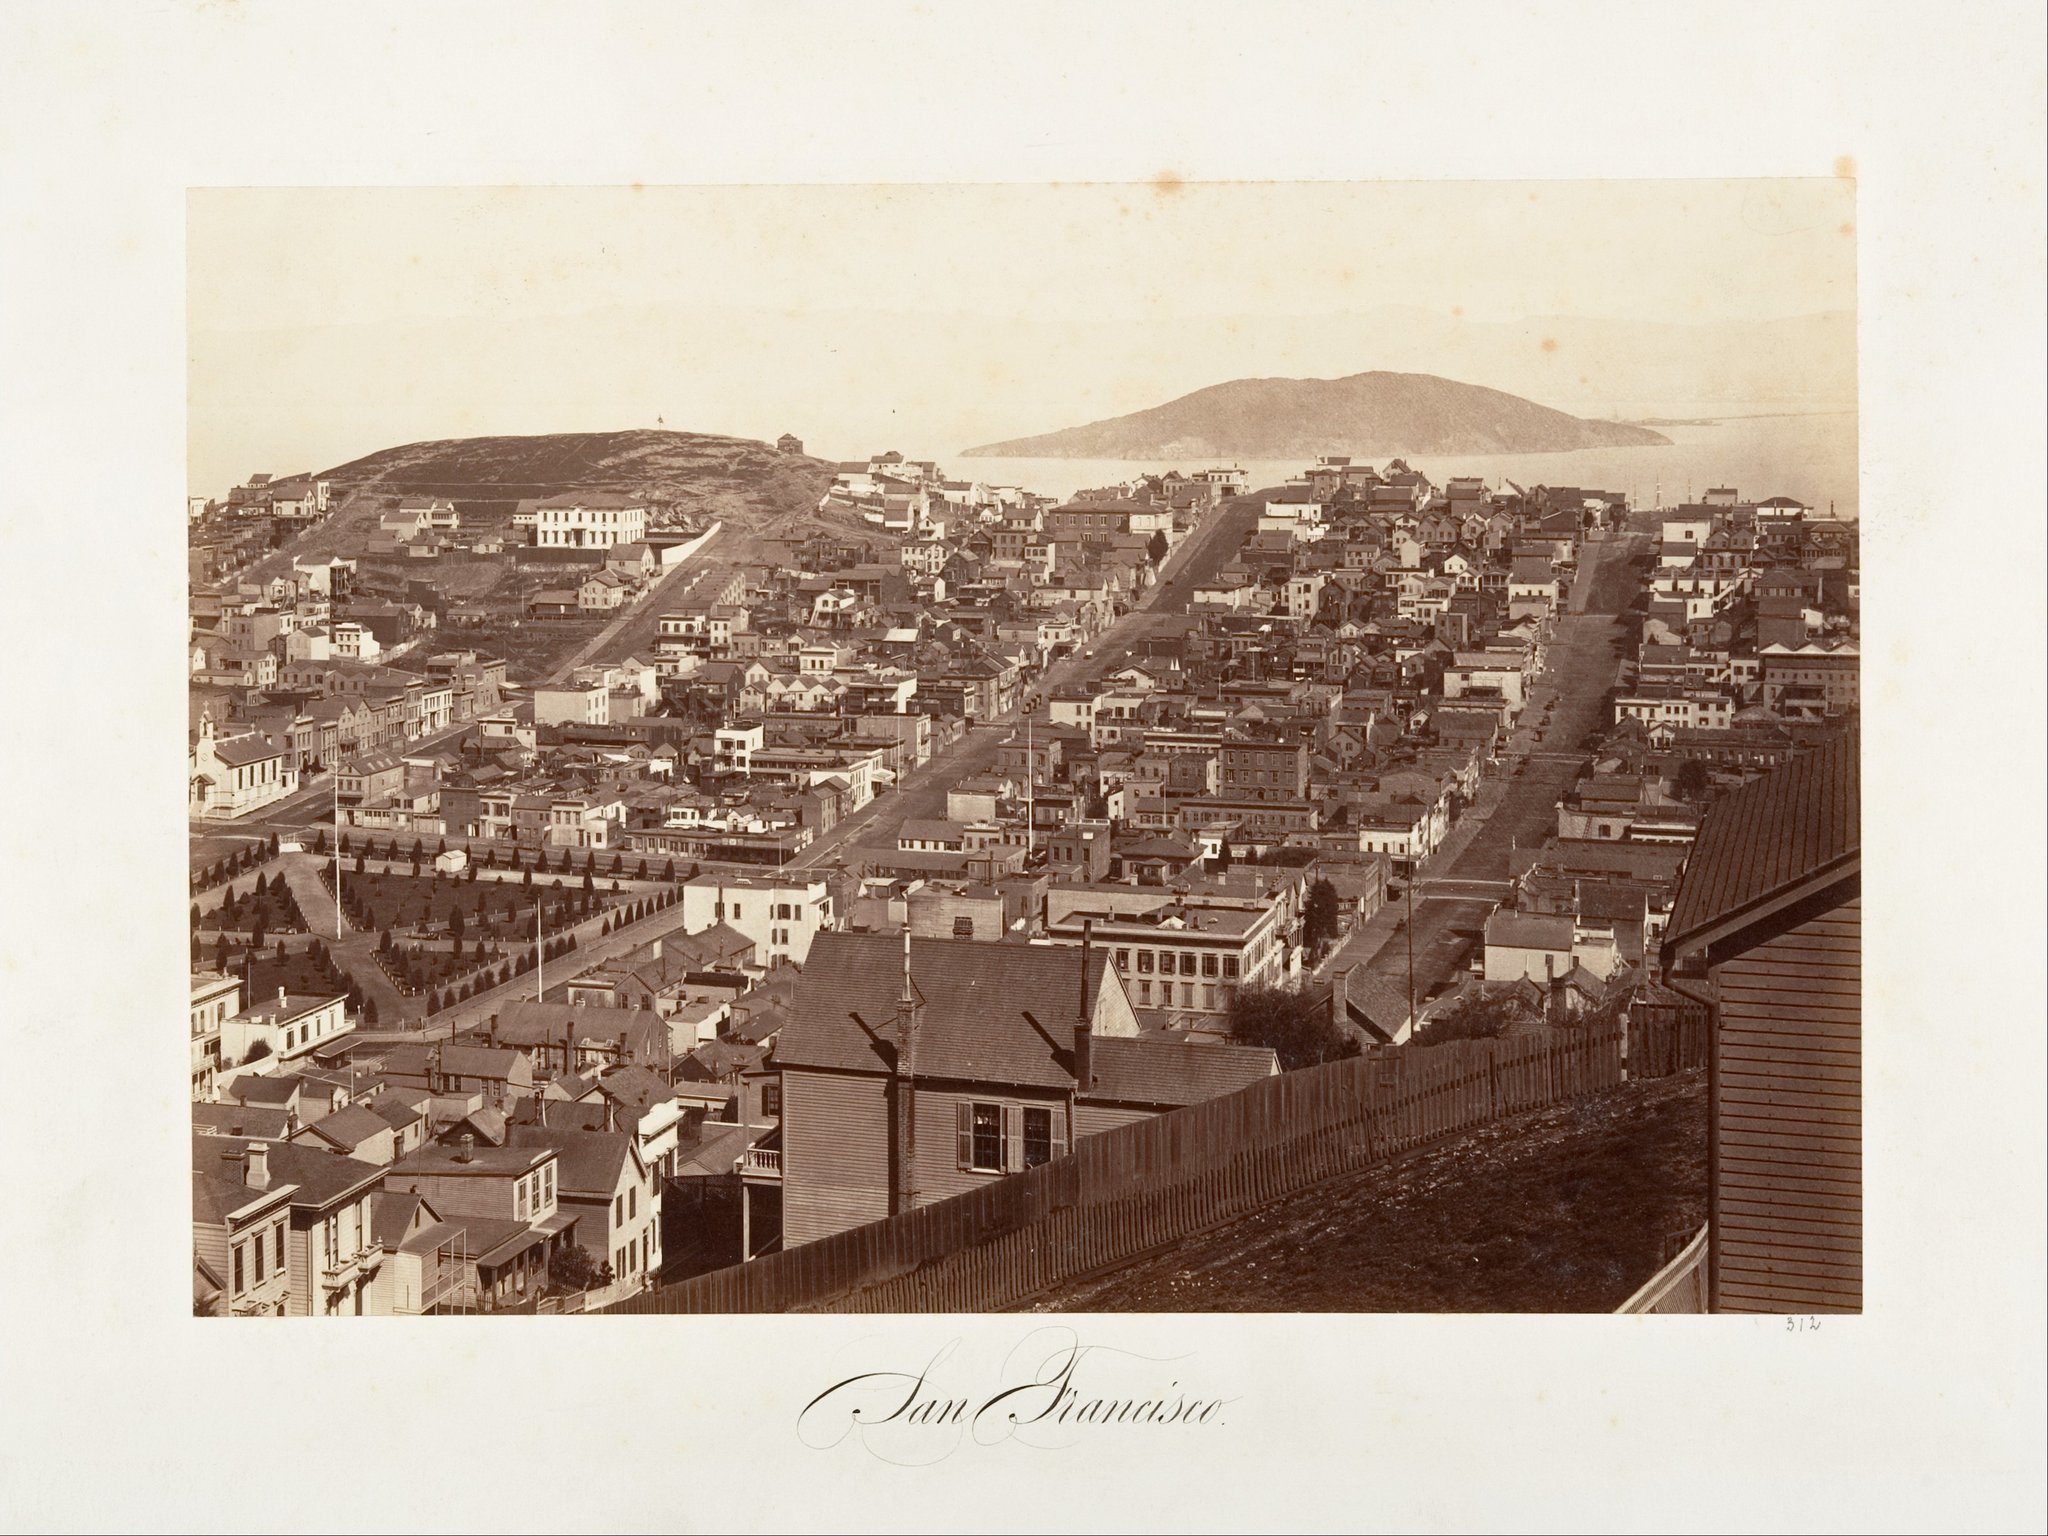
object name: photograph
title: San Francisco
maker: carleton e. watkins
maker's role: artist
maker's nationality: american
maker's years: 1829-1916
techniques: albumen silver print, glass negative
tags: cities